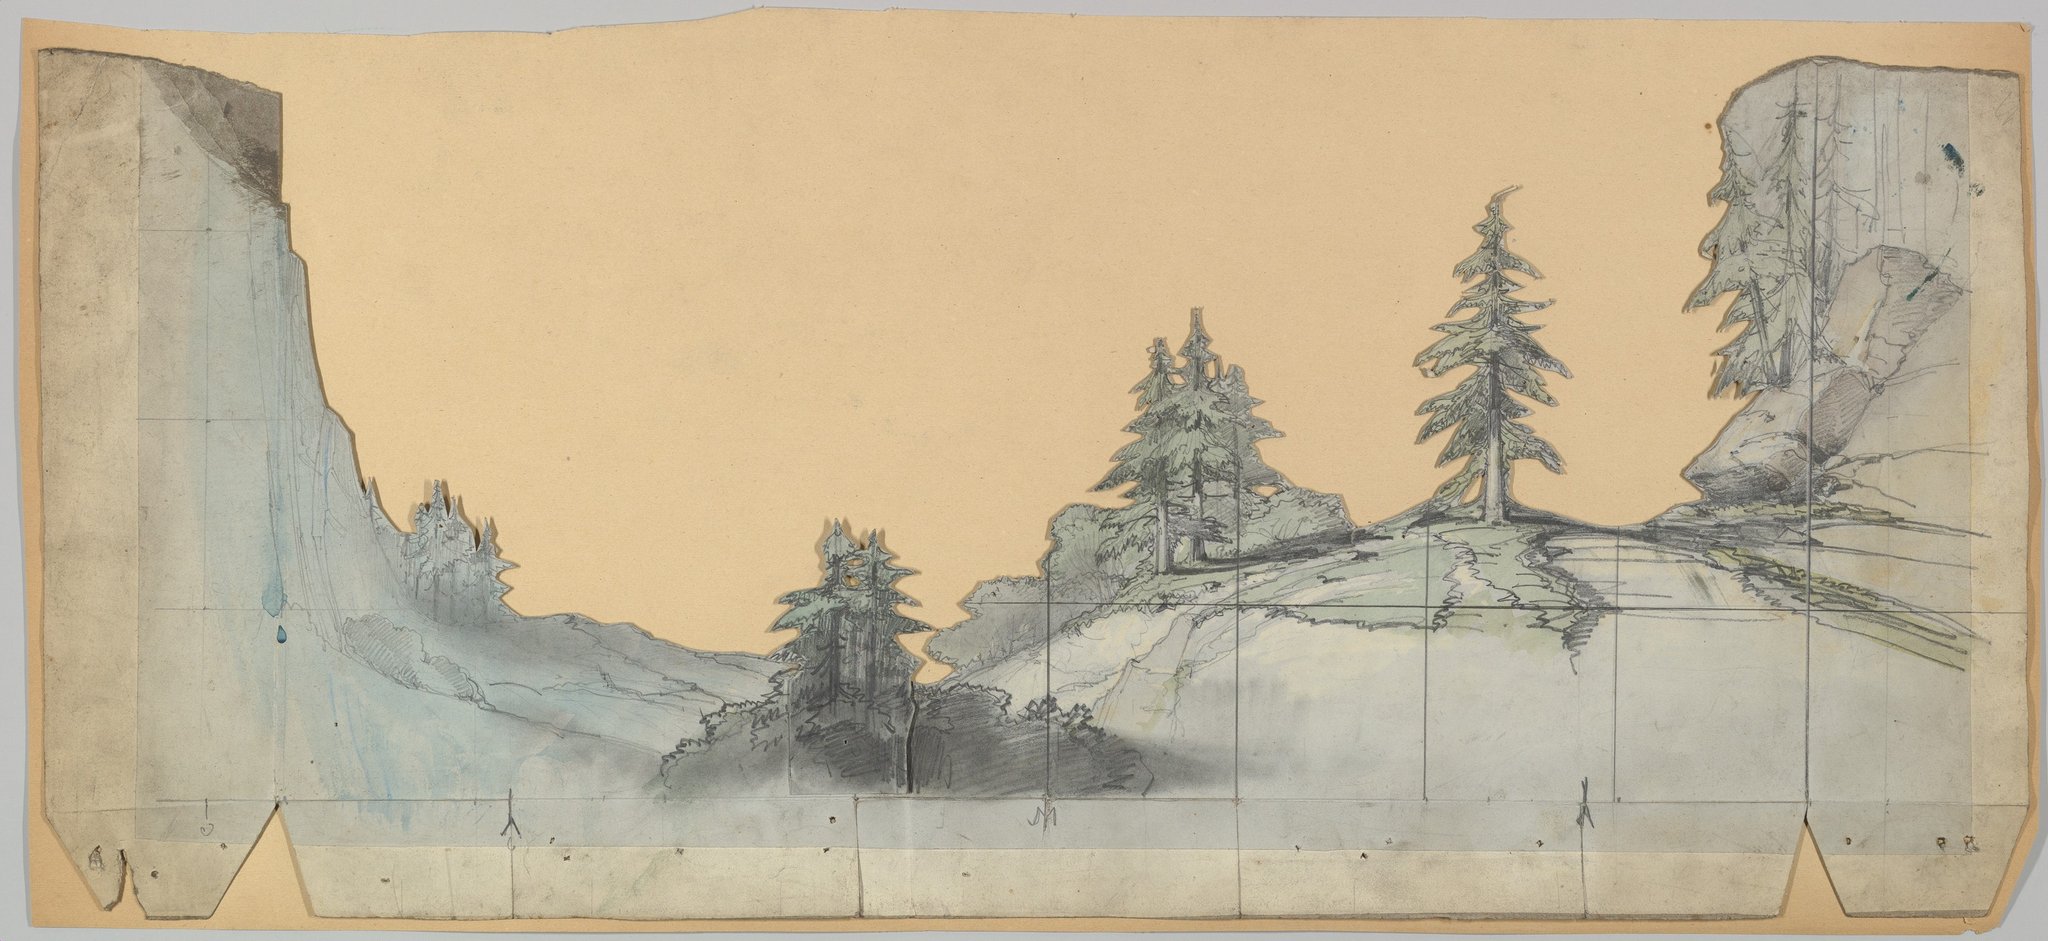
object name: drawing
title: Design for a Stage Set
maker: eugène cicéri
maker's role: artist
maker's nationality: french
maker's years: 1813-1890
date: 1830-1890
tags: trees,stage design